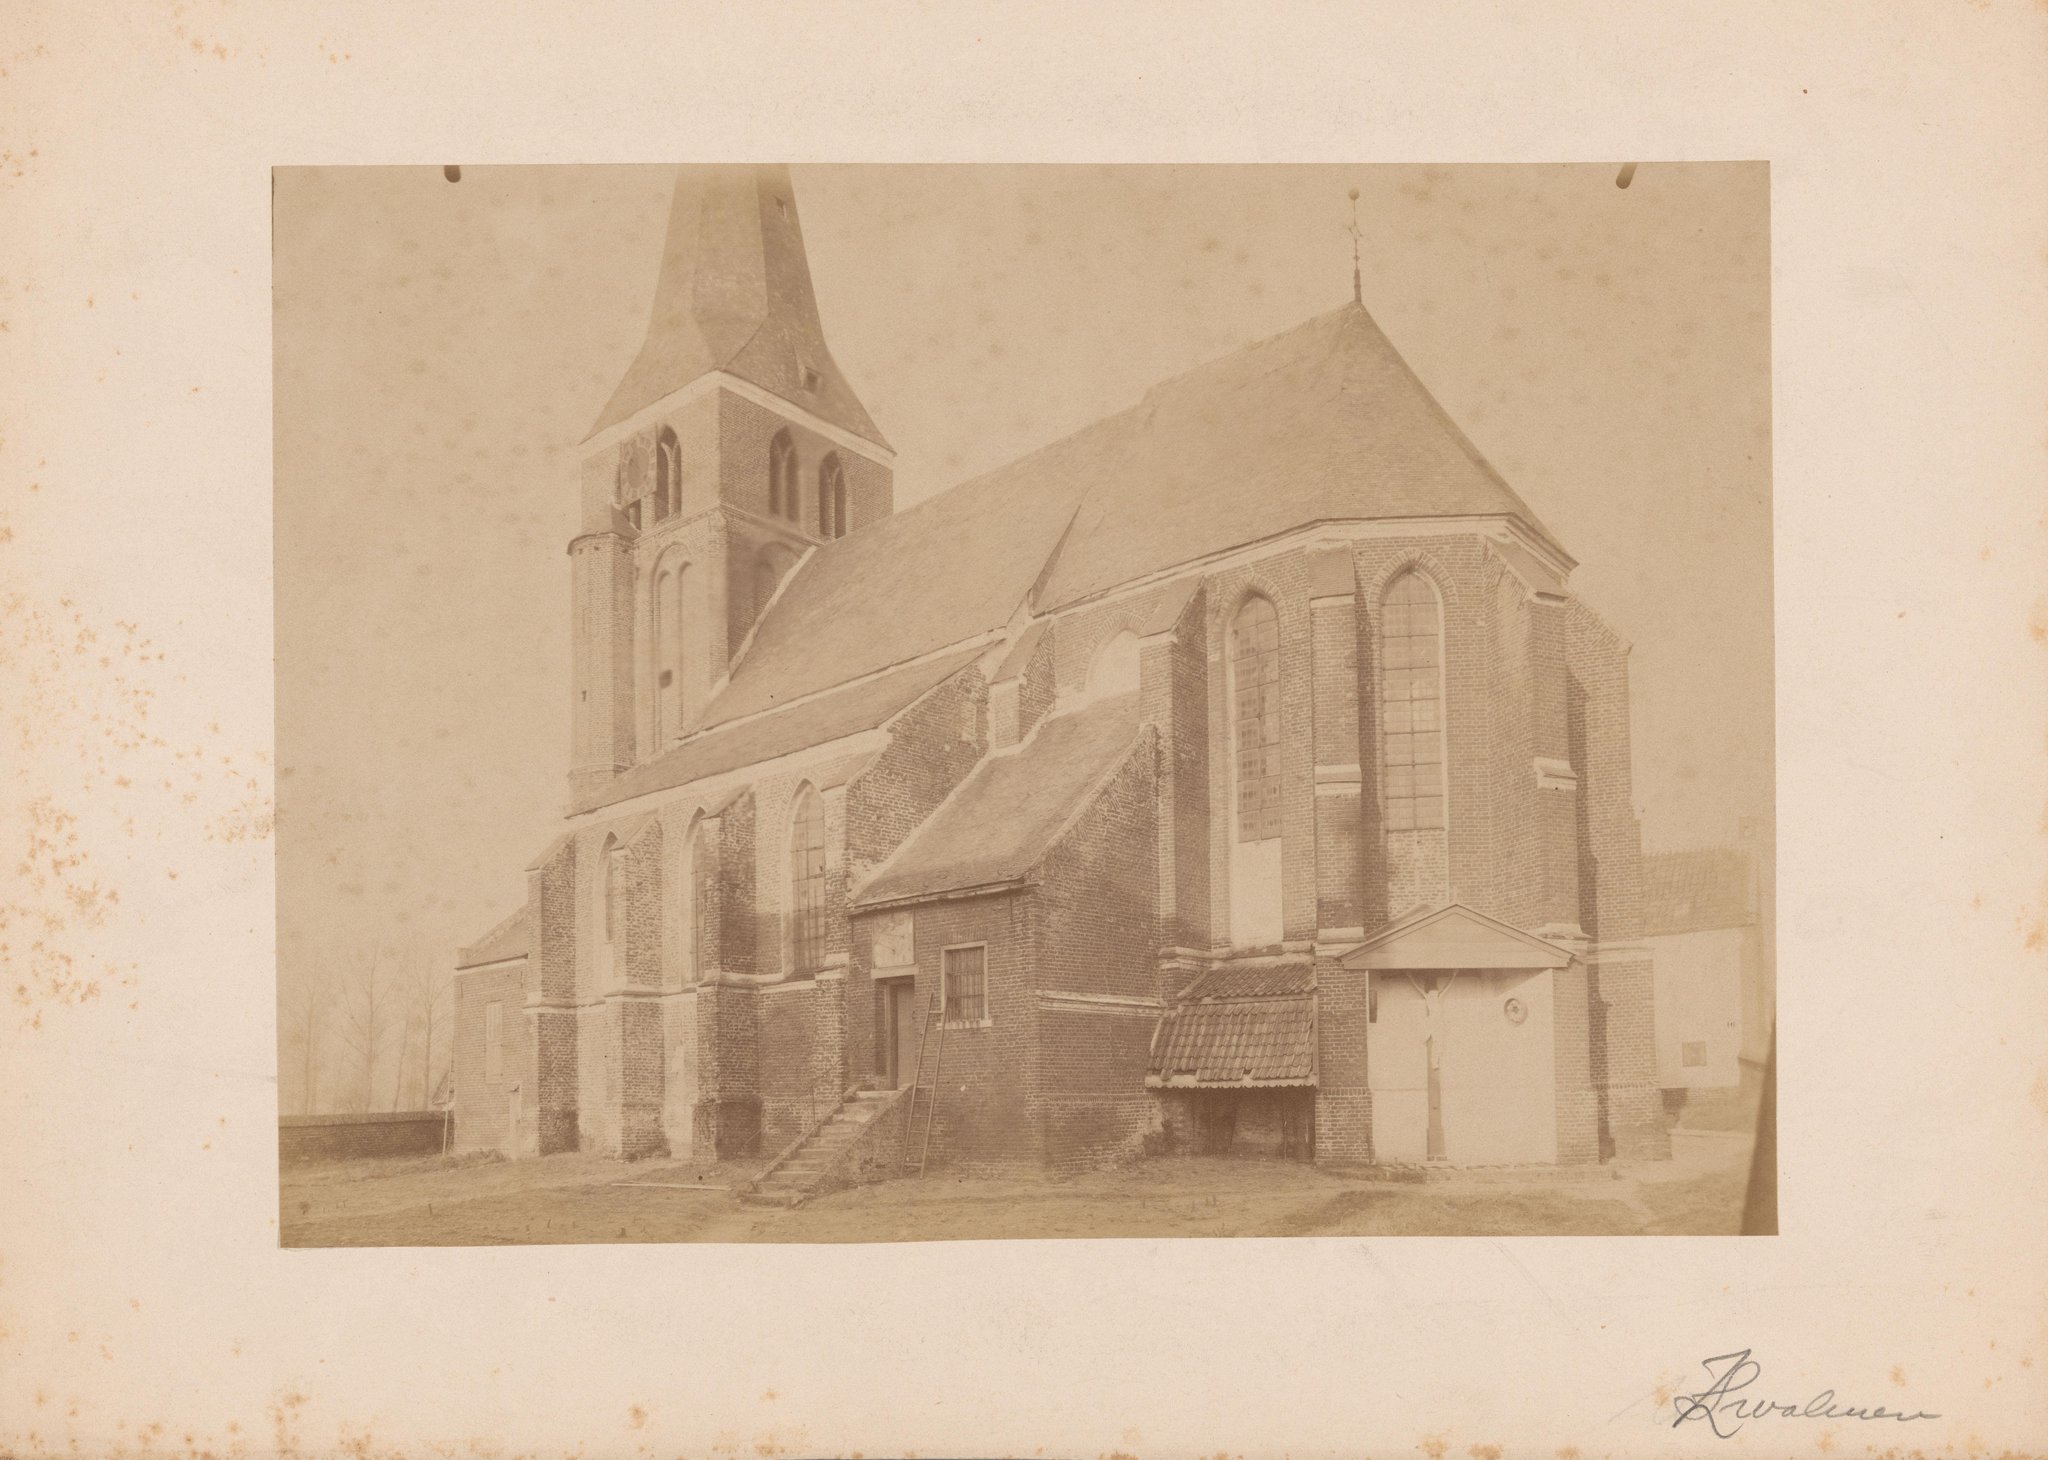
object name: photograph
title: Zuidzijde van de Sint-Lambertuskerk te Swalmen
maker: anoniem (monumentenzorg)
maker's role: fotograaf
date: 1895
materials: cardboard, photographic support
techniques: albumen print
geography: swalmen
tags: church (exterior)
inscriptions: annotation: ‘Swalmen (L.)/ R.K. Kerk zuidzijde/ Nov-Dec 95’, annotation: ‘Swalmen’